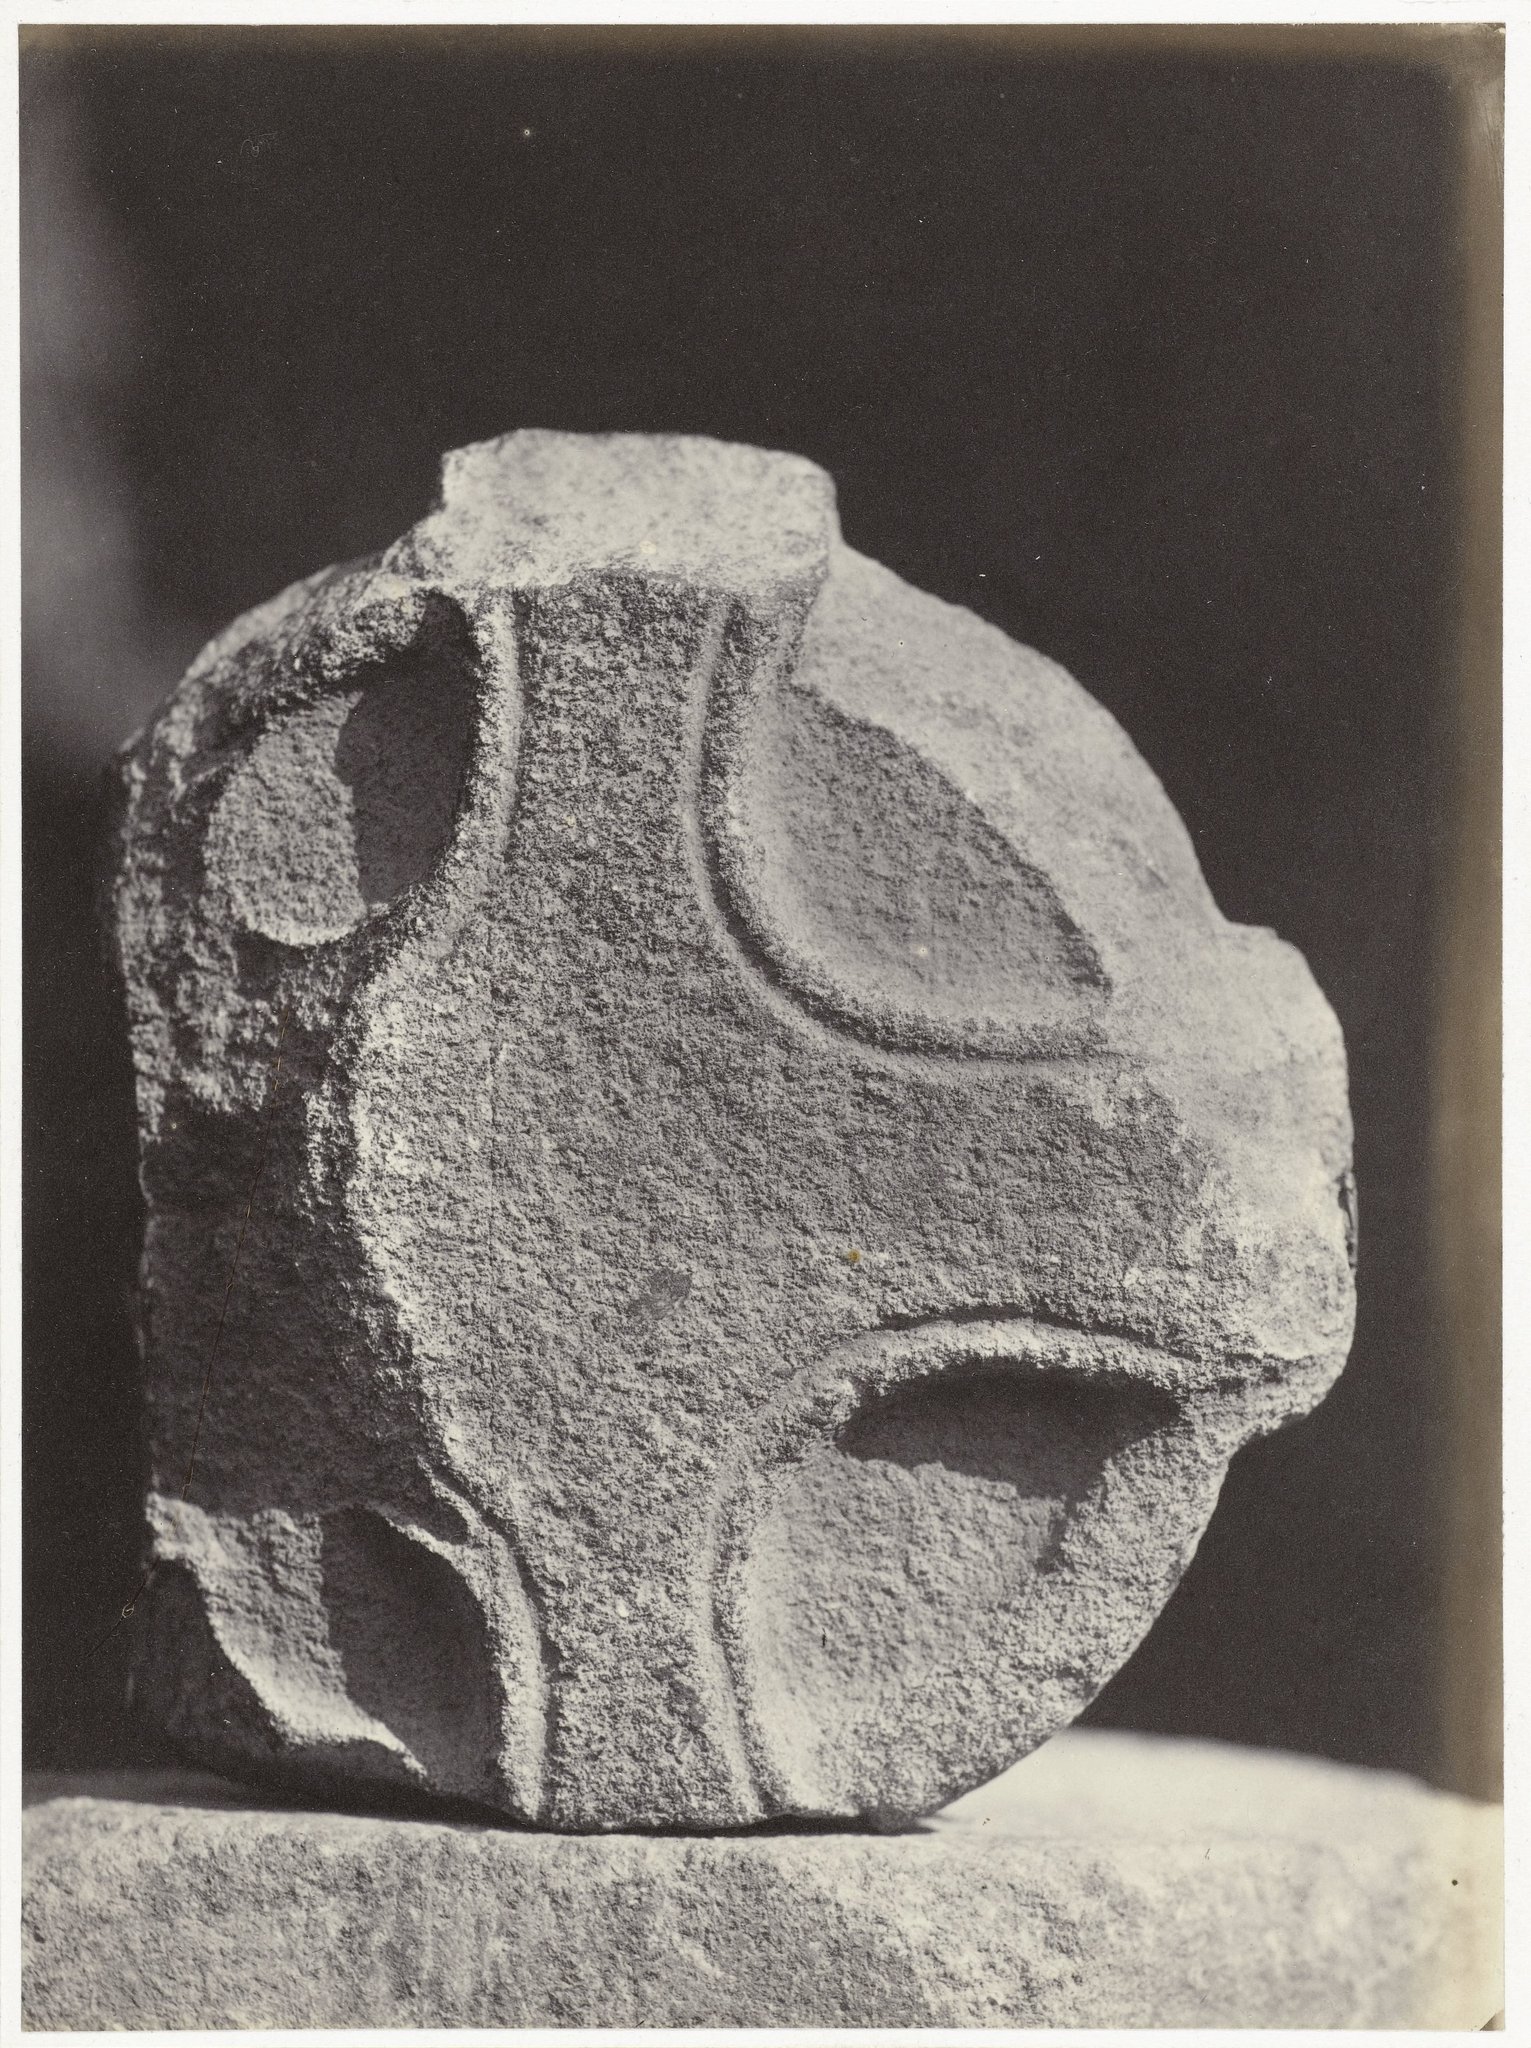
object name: photograph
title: Stenen kruis, Keltisch of Iers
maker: francis edmond currey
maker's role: fotograaf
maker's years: 1814-1896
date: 1851-1890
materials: paper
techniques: albumen print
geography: great britain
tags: cross as symbol of christ, great britain